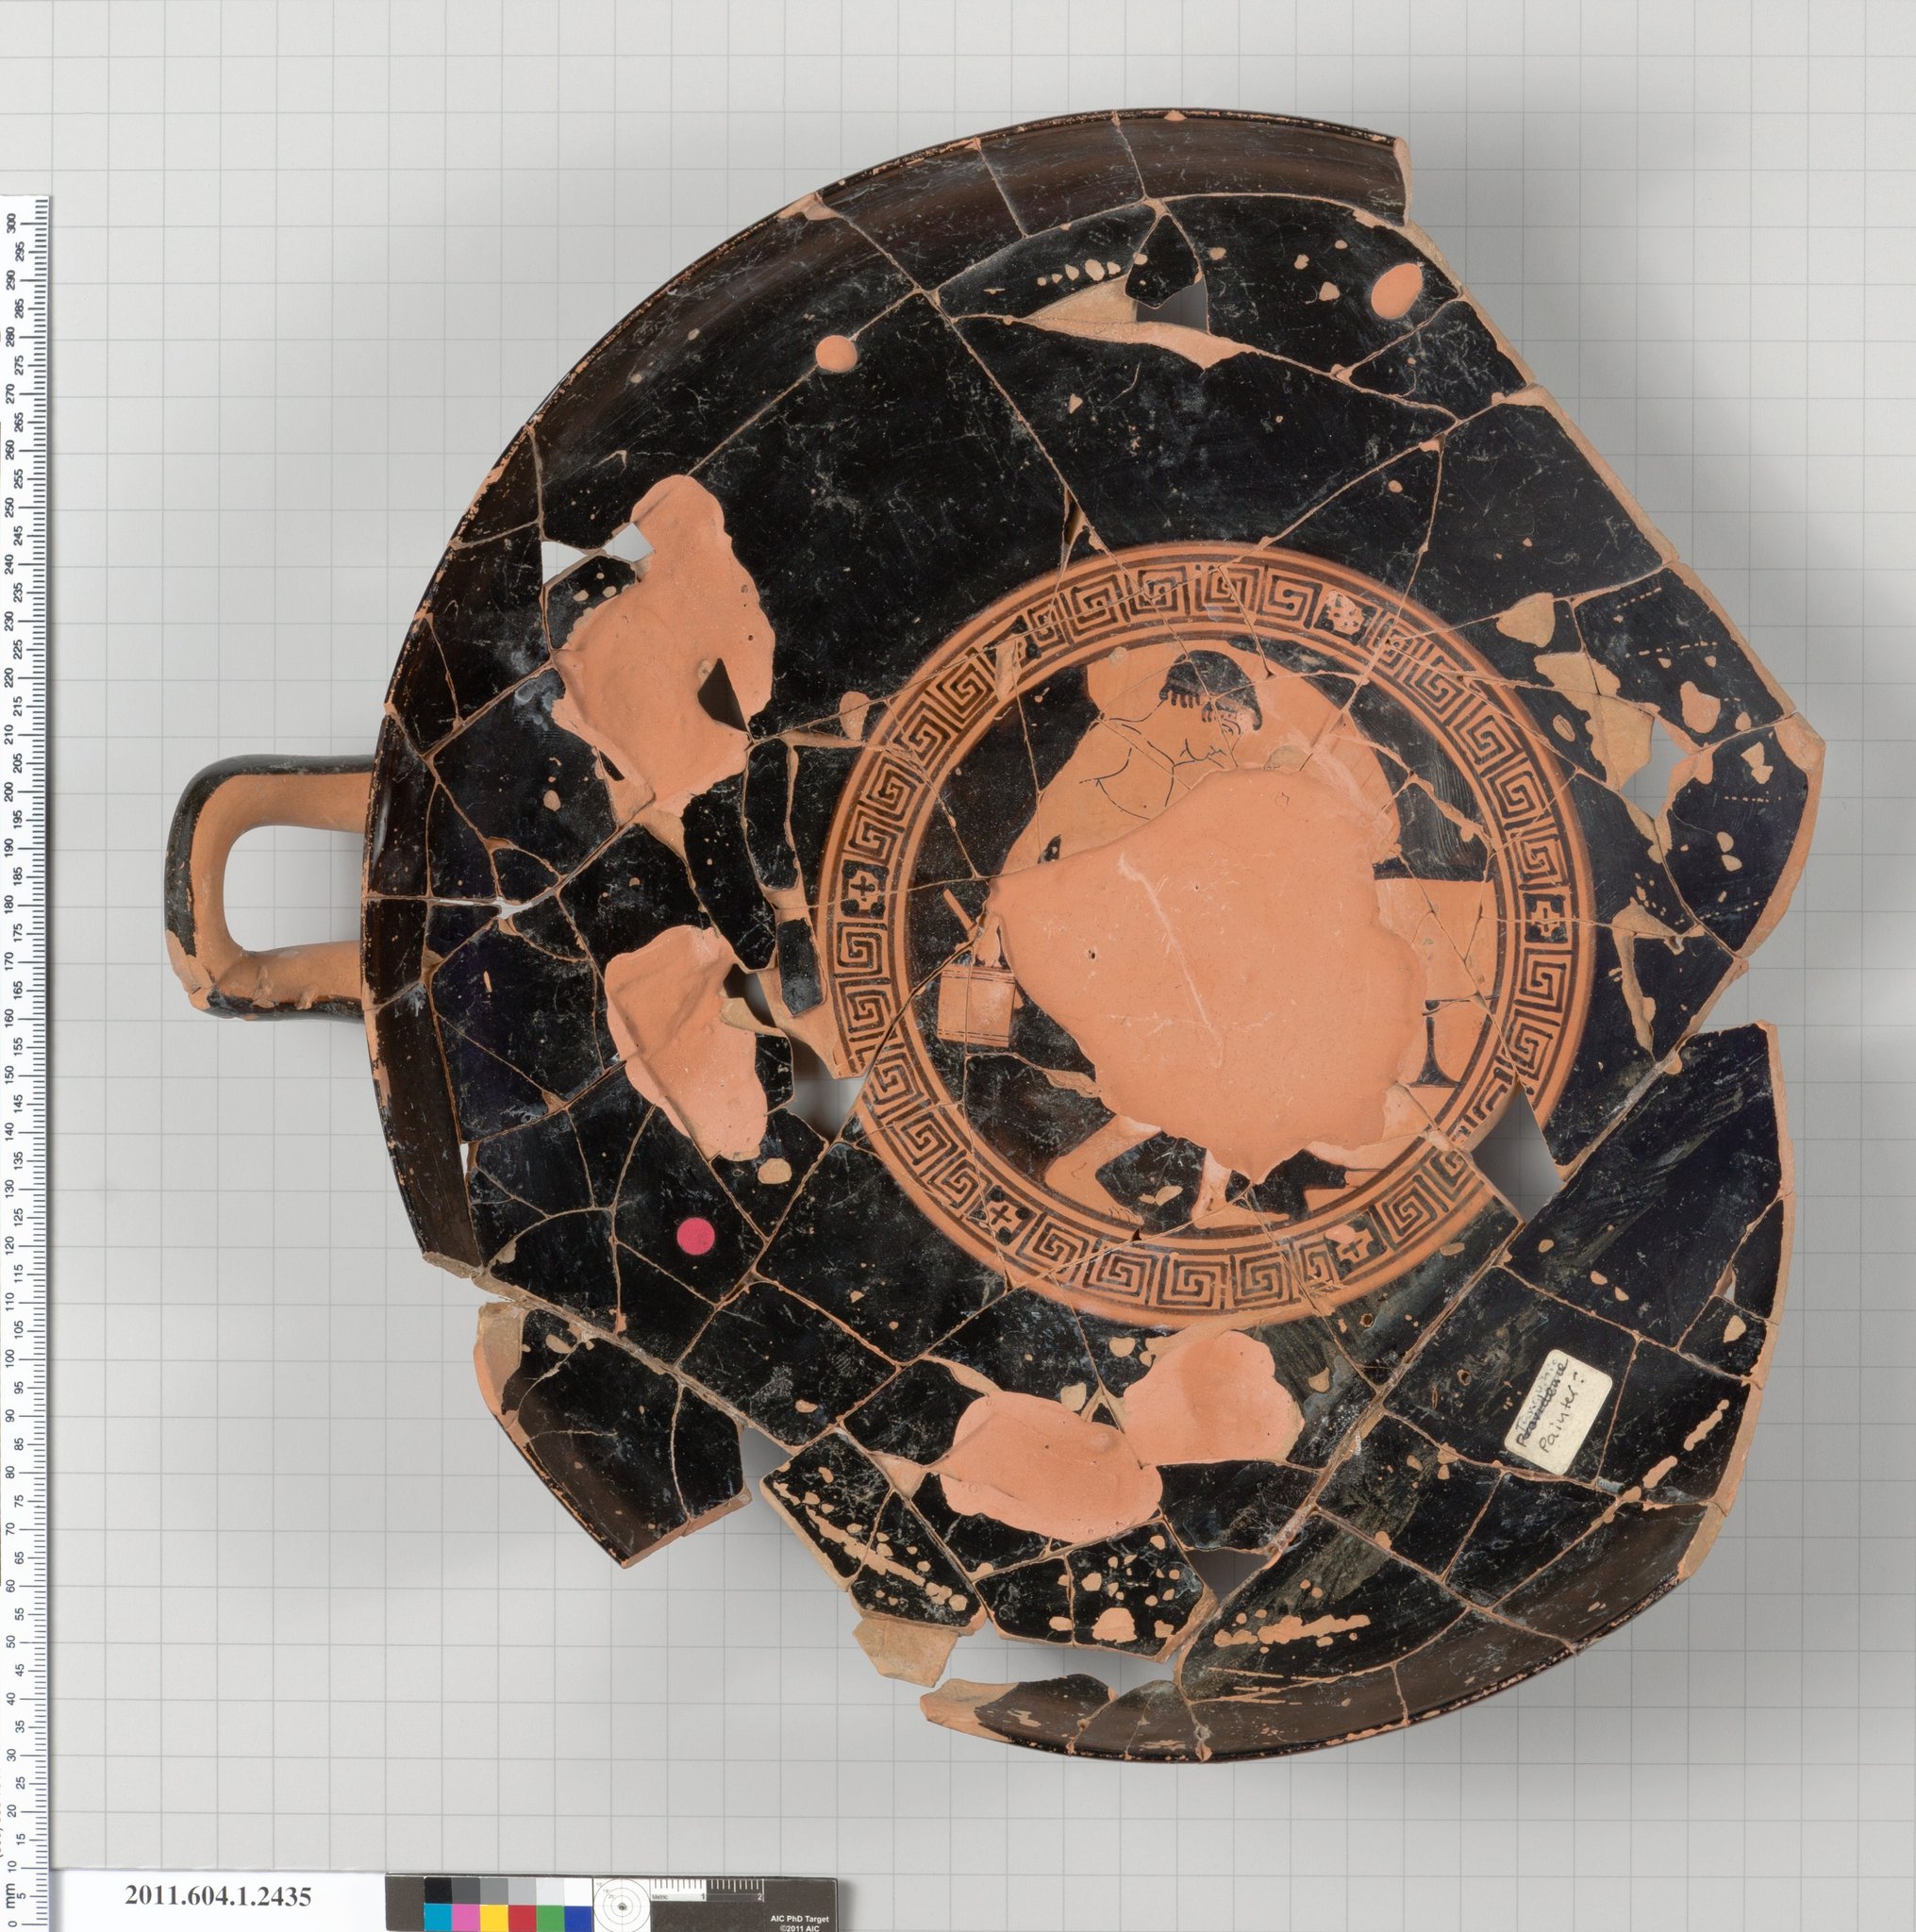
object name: kylix fragment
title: Terracotta fragment of a kylix (drinking cup)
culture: greek, attic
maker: tarquinia painter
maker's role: artist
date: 470-460 BCE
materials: terracotta